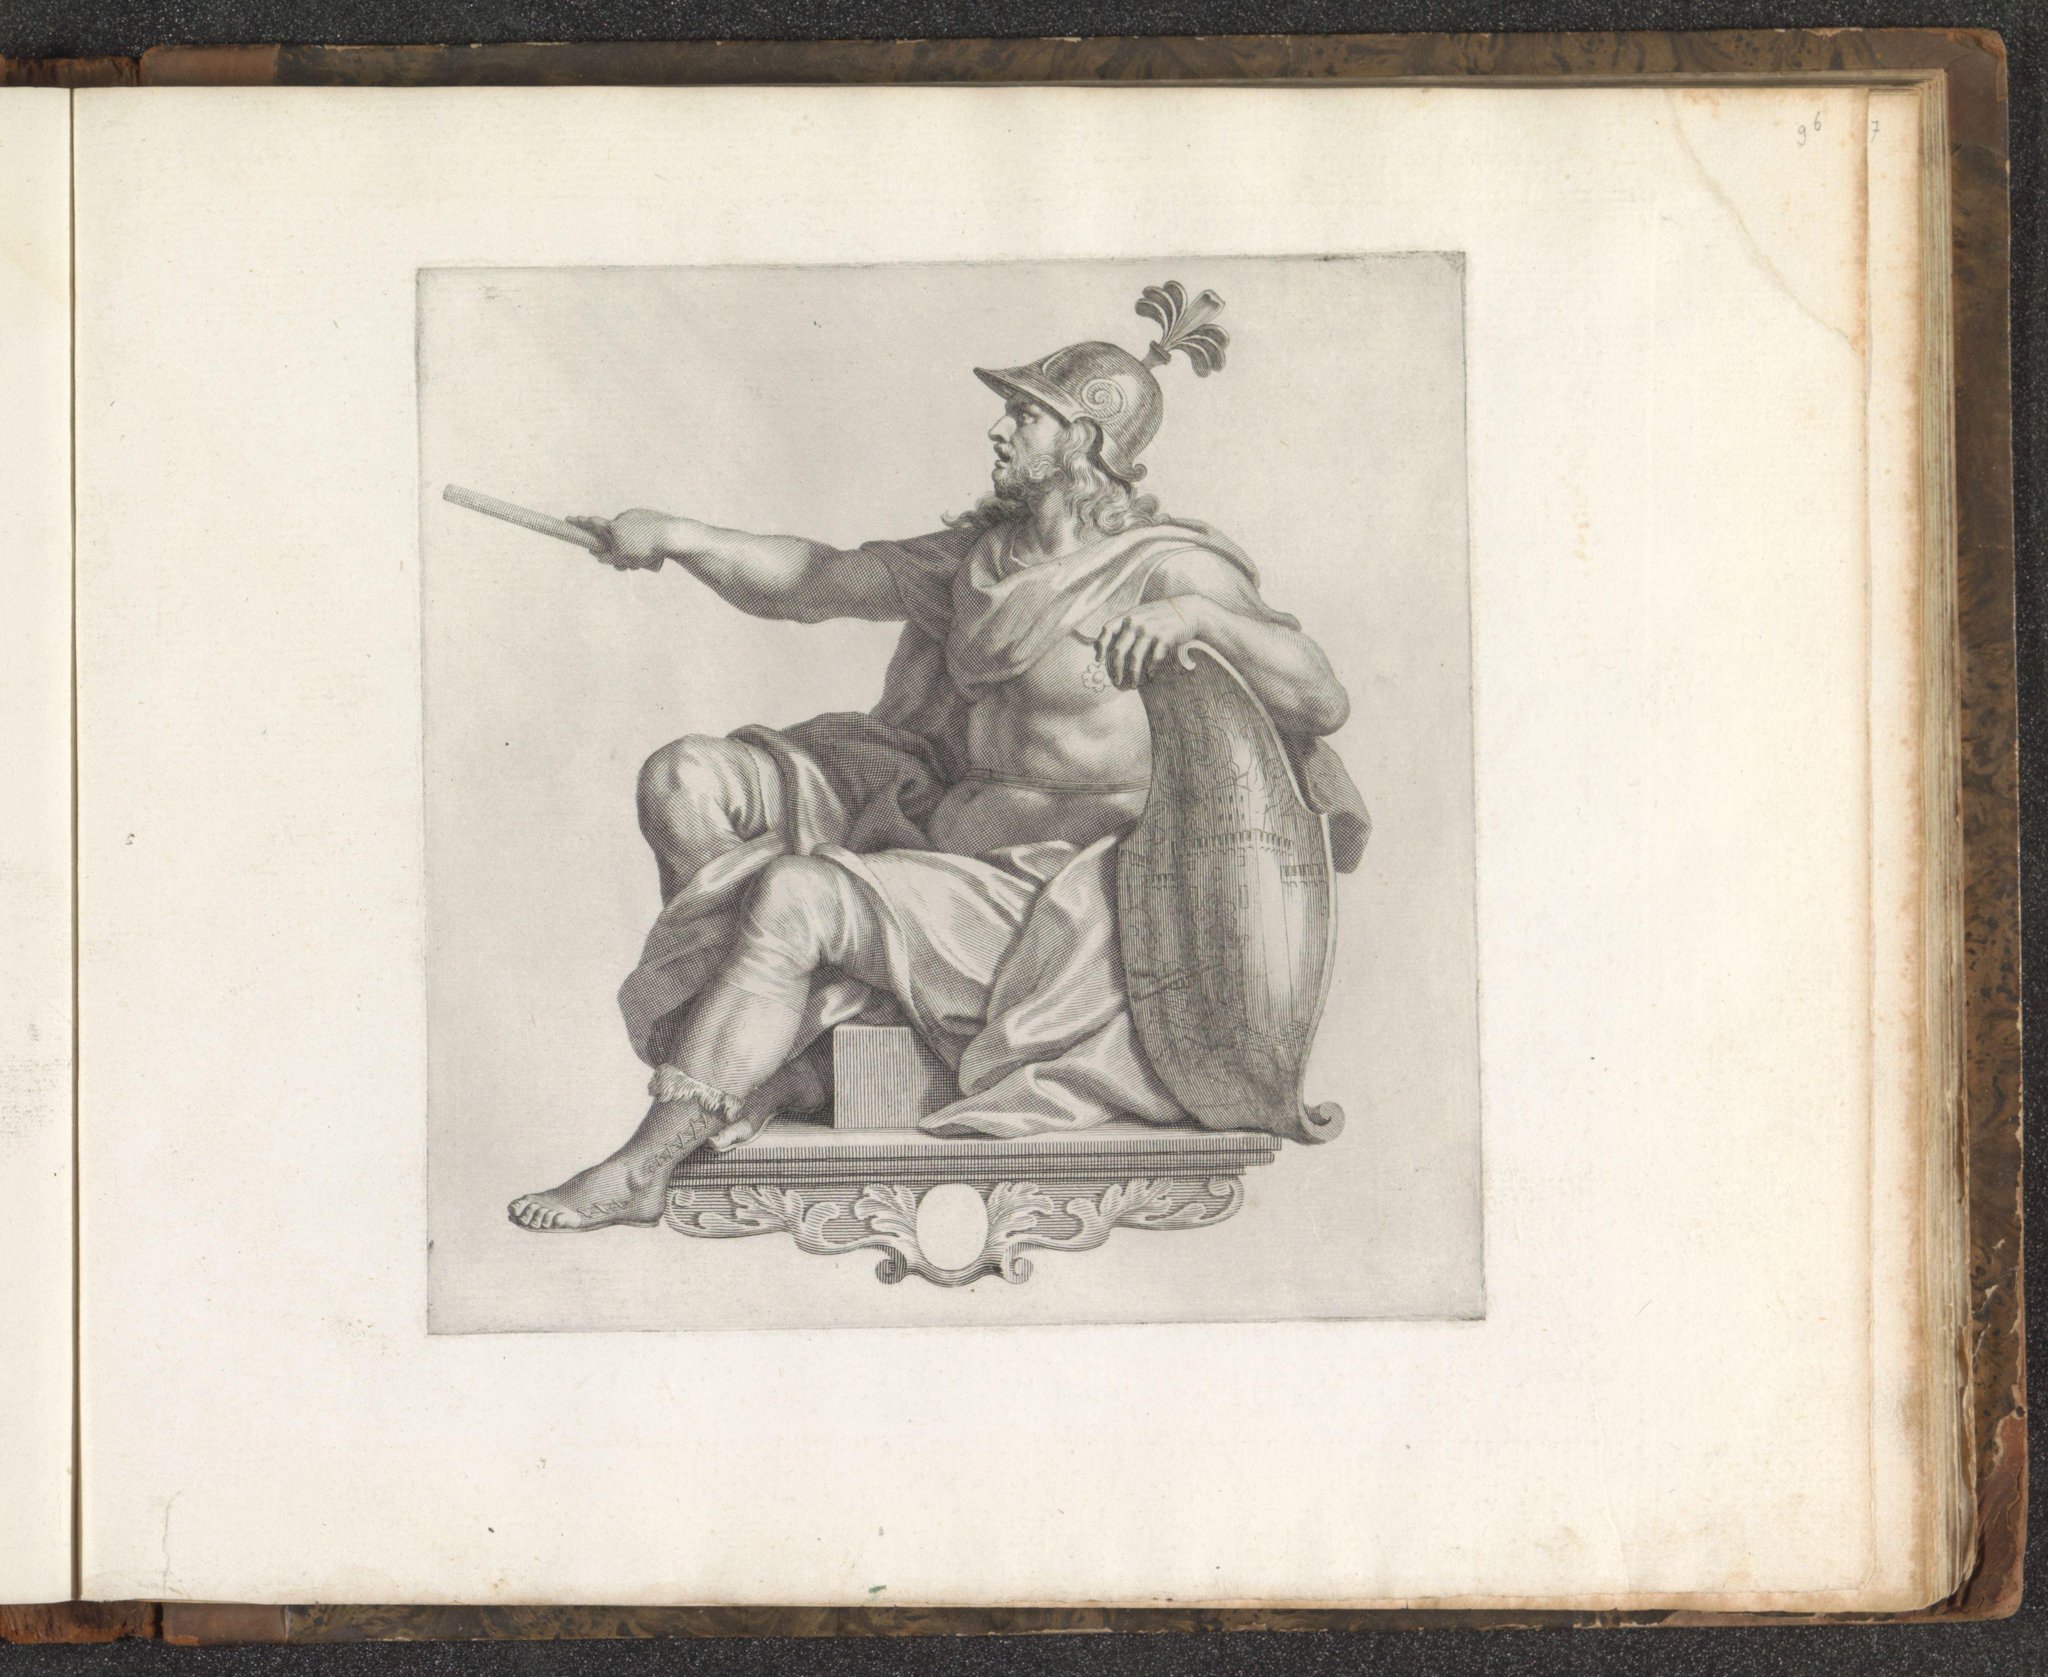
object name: album leaf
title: Personificatie van de Oorlogsverklaring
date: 1673-1743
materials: paper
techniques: engraving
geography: rome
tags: declaration of war, setting on fire (of conquered city)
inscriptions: collector's mark: Lugt 2228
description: Een console met een geharnaste man. Hij steekt zijn commandostaf naar voren. Op zijn wapenschild wordt een stad in brand gestoken. De prent maakt deel uit van een album.